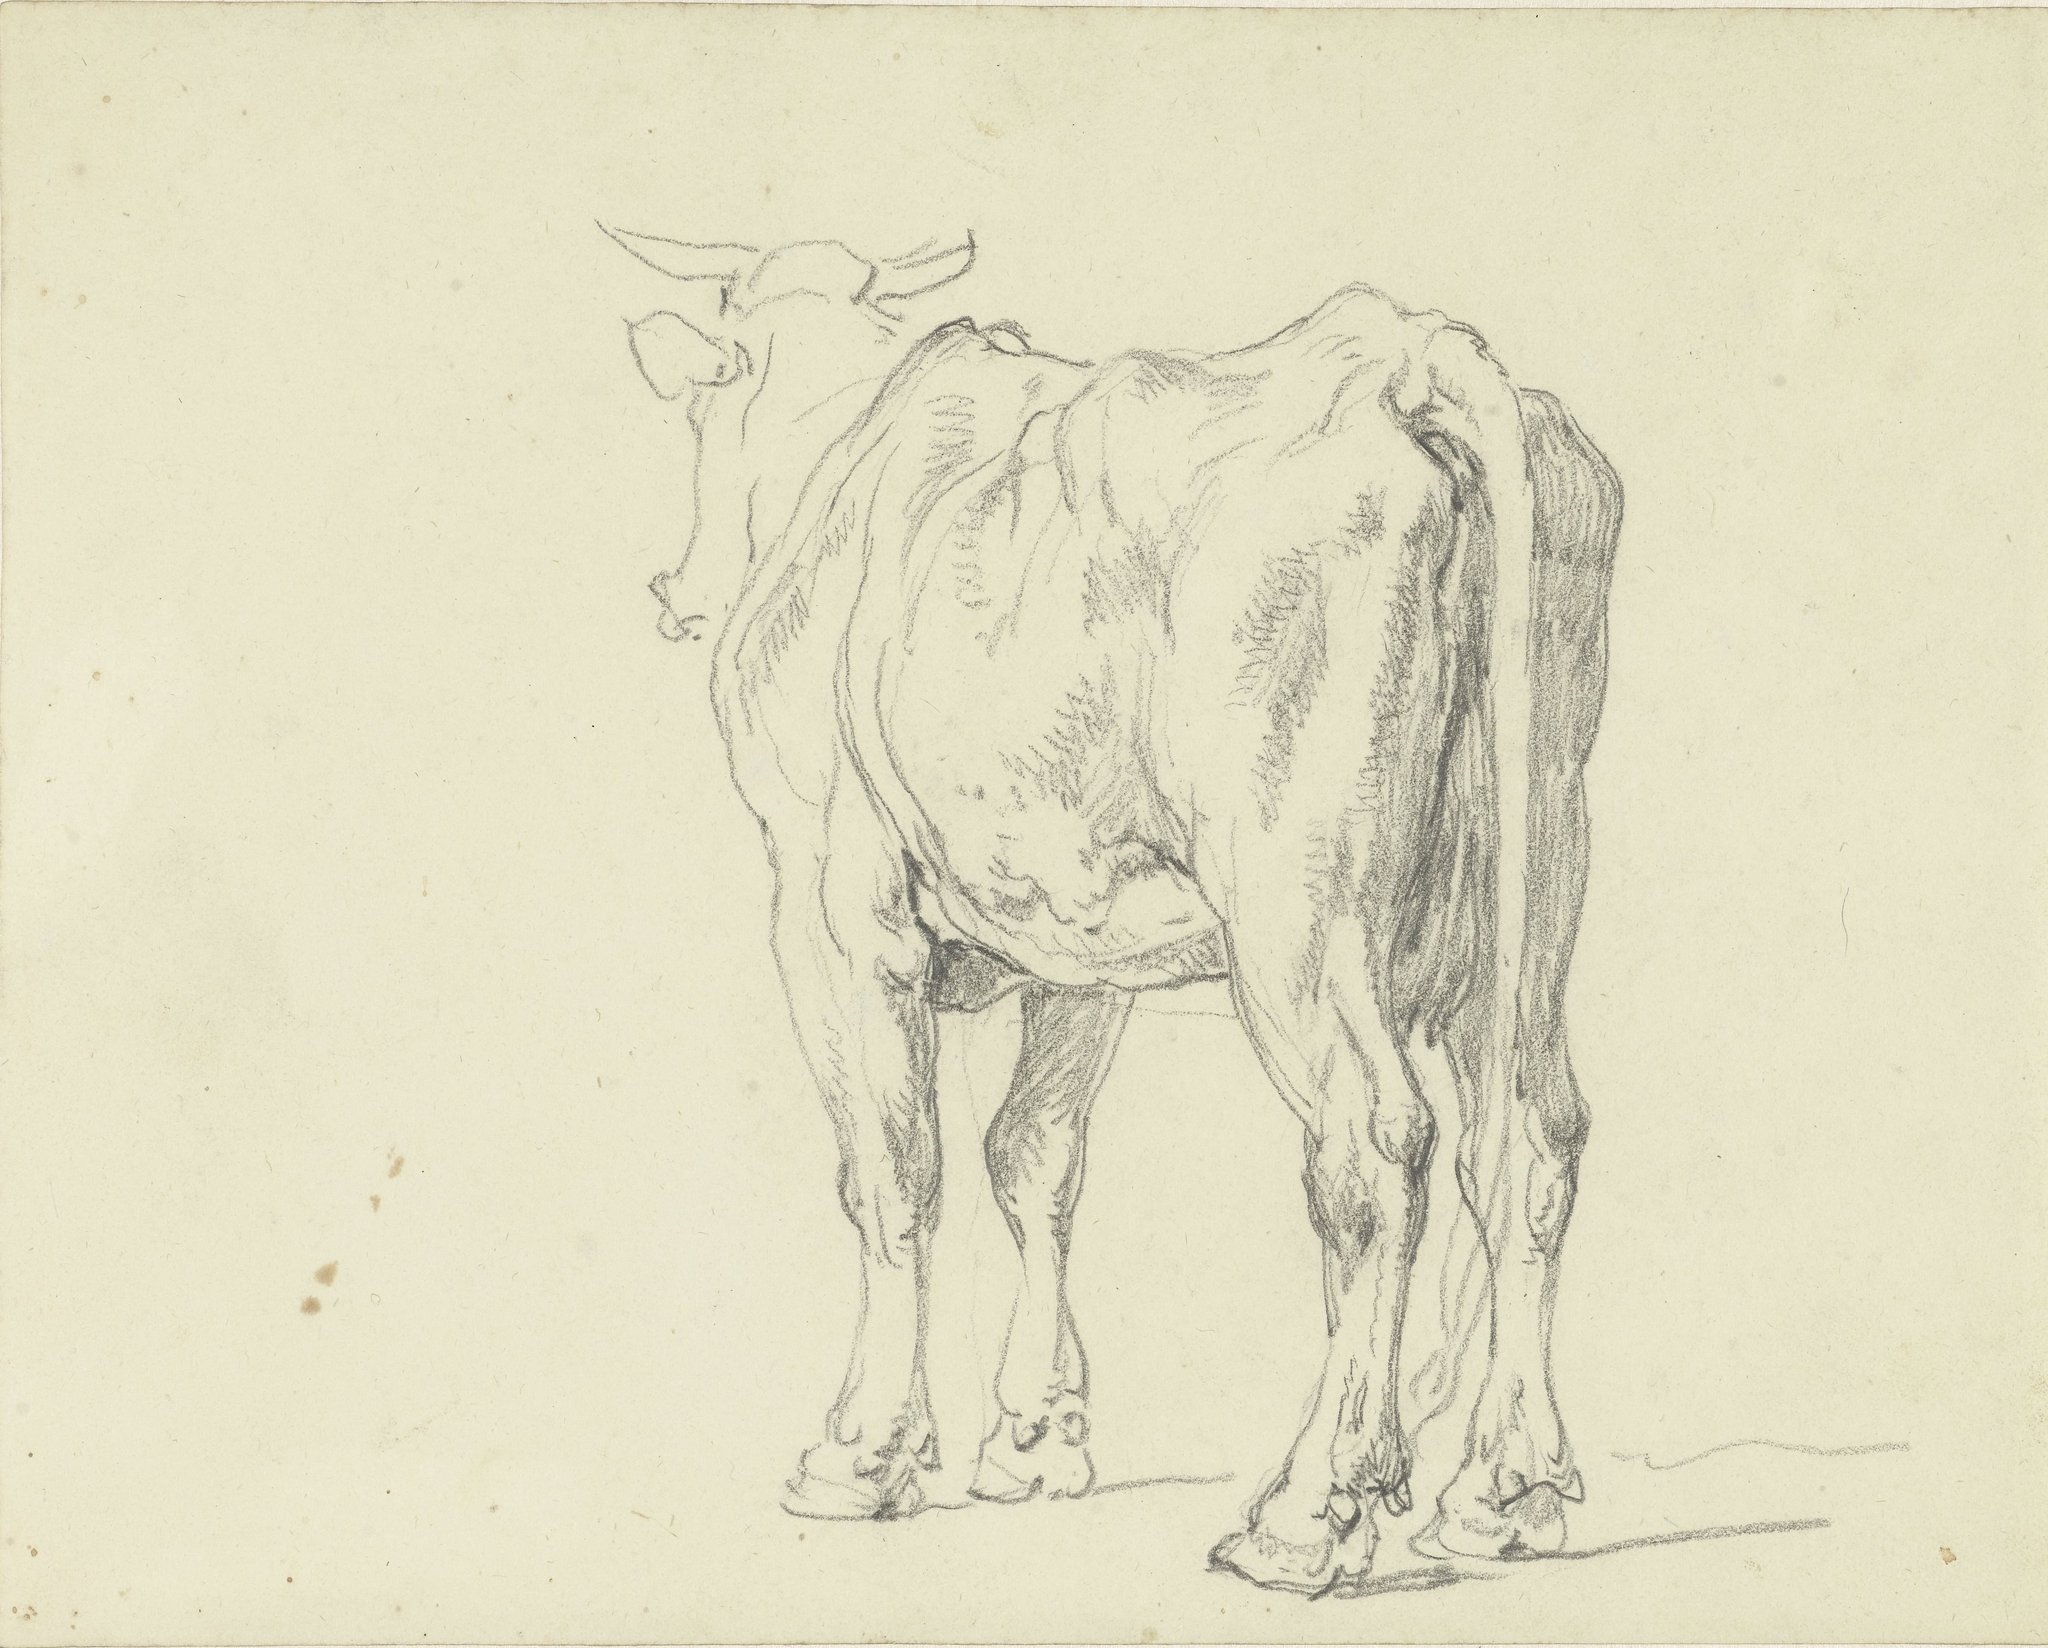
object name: drawing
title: Staande koe, van achteren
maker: hendrik voogd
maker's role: draughtsman, painter, print maker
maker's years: 1768-1839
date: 1788-1839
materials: paper, pencil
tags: cow